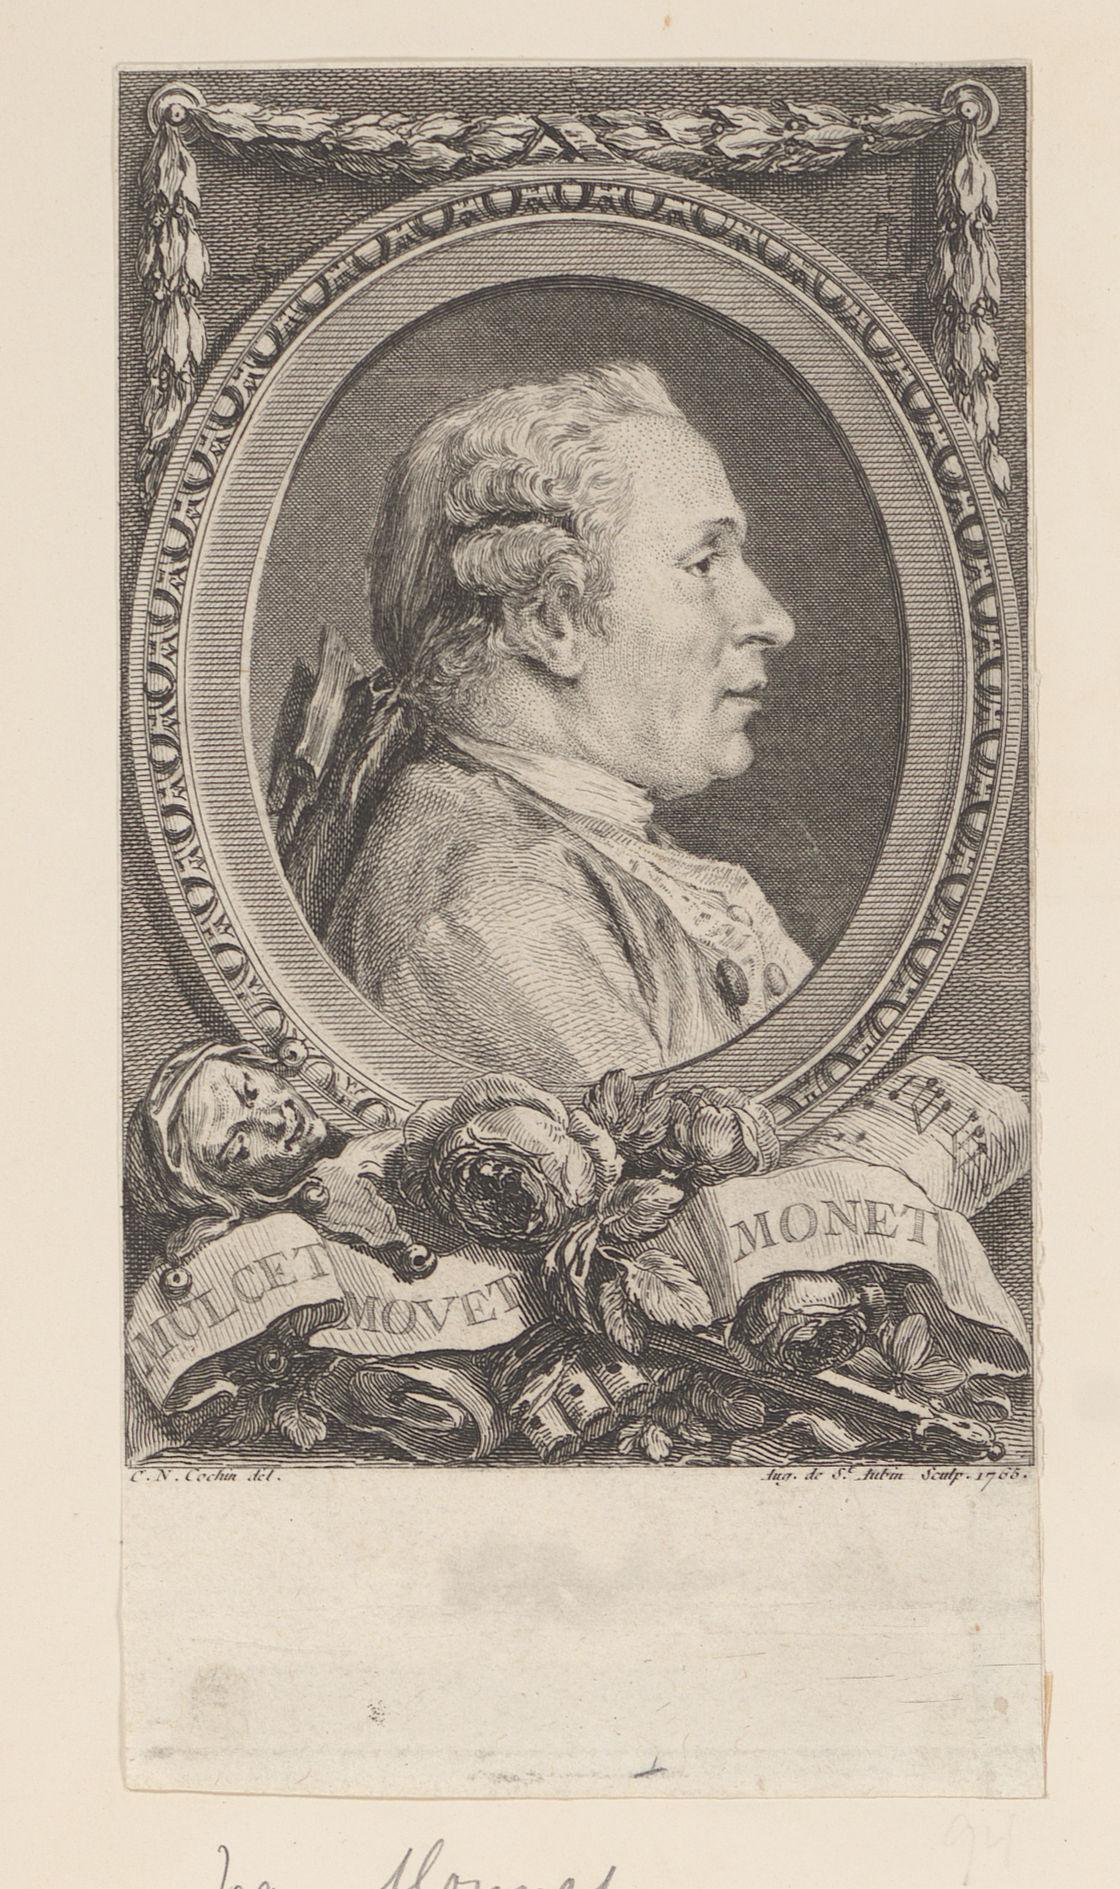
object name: print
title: Portret van Jean Monnet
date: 1765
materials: paper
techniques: engraving, etching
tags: historical persons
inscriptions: date